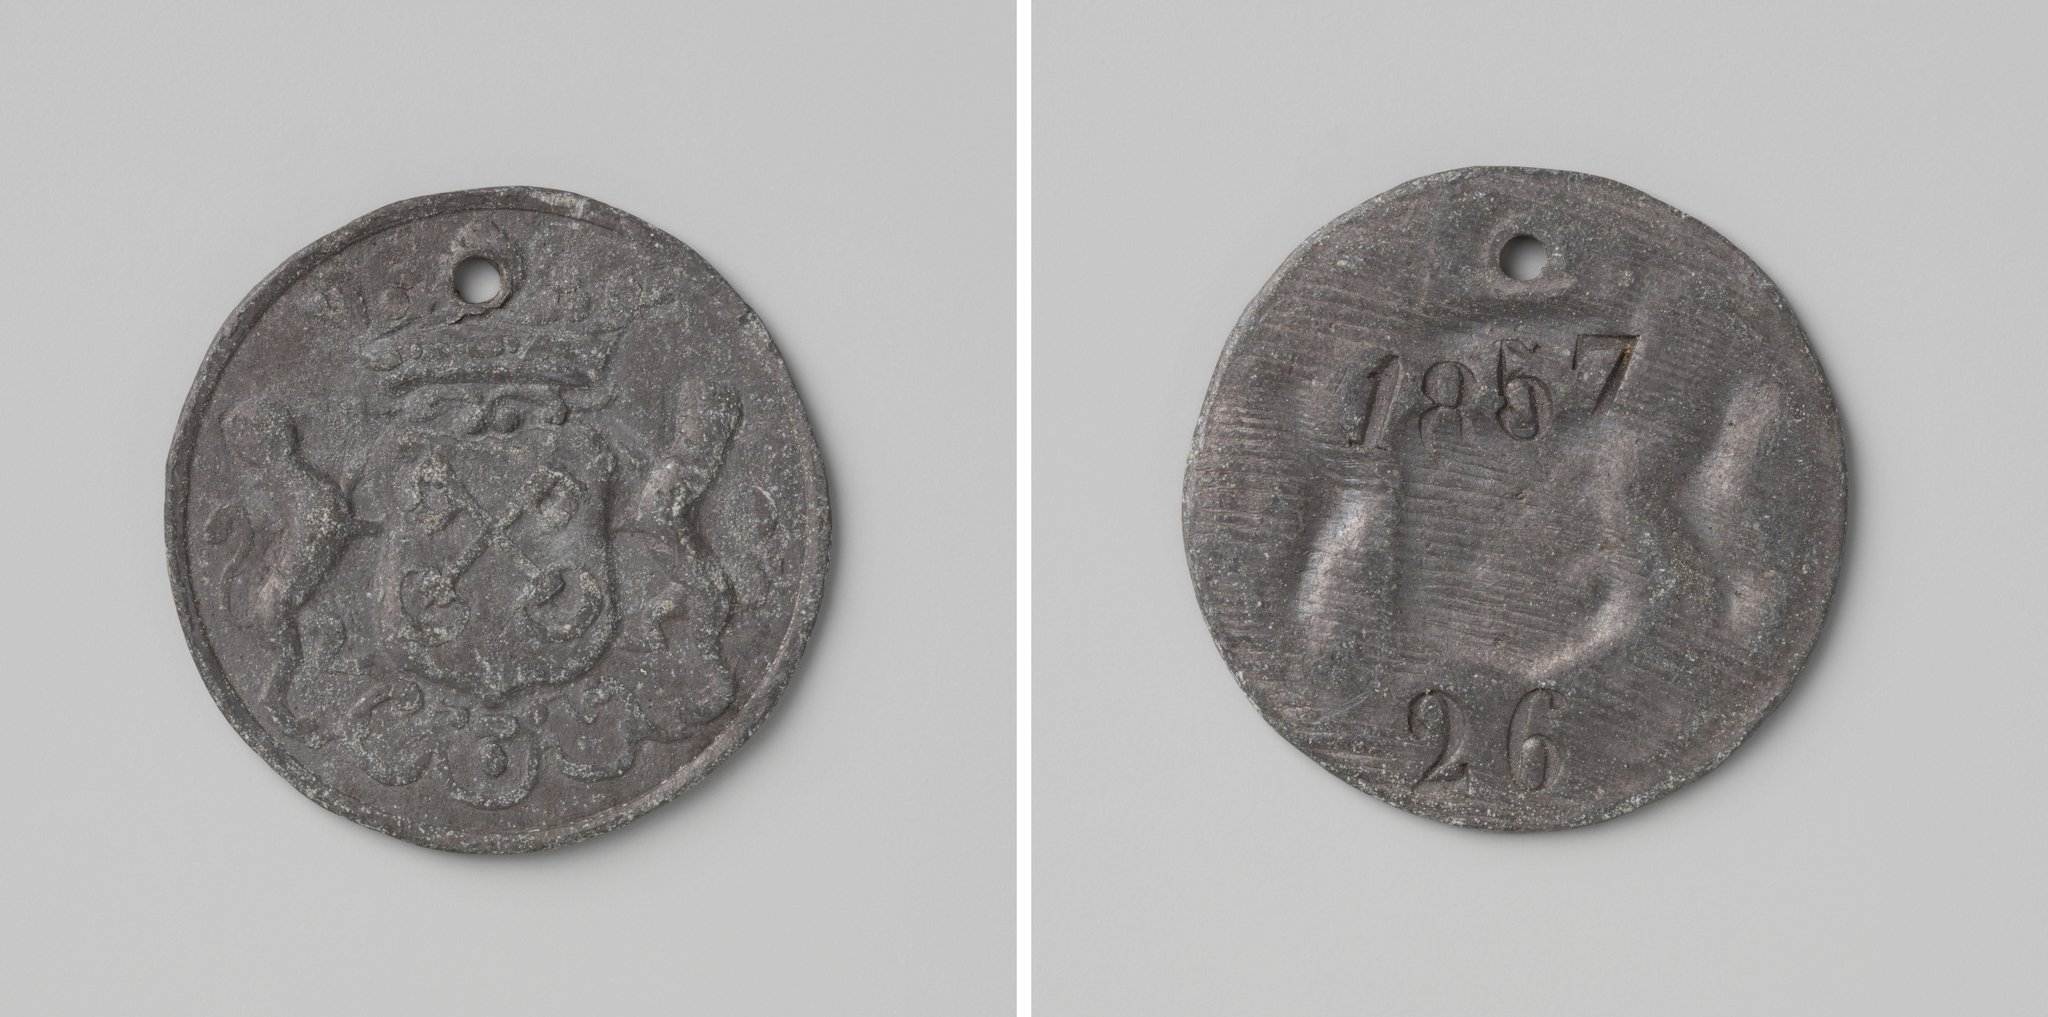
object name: armenloodje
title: Stad Leiden, loodje met no. 26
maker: Anonymous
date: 1857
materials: lead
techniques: casting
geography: leiden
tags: leiden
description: loodje met gat erin. Voorzijde: gekroond wapenschild geflankeerd door twee leeuwen. Keerzijde: jaartal boven cijfer 26